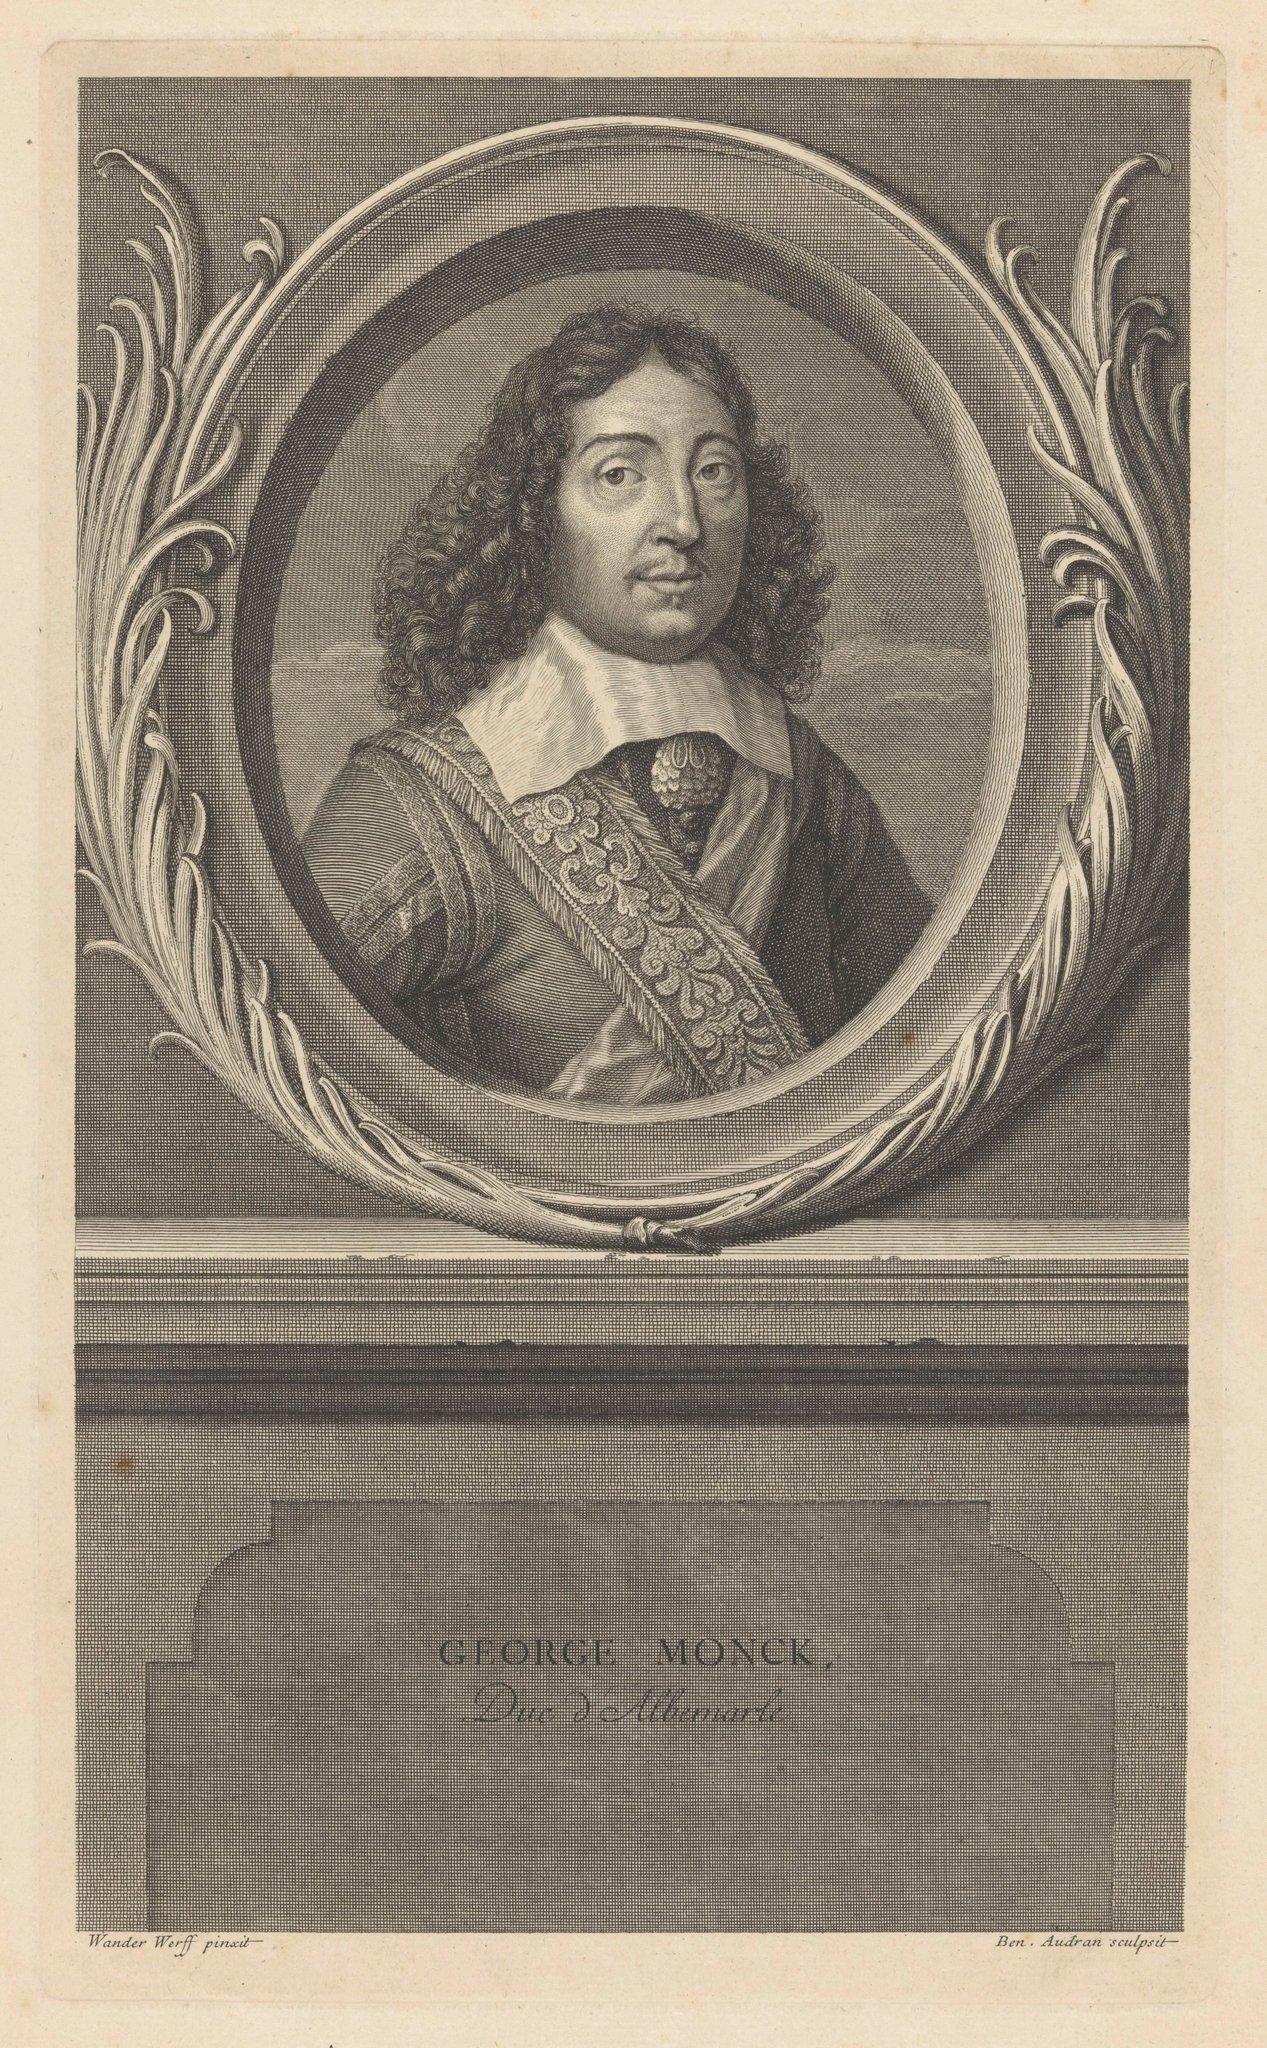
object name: print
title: Portret van George Monck, hertog van Albemarle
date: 1671-1721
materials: paper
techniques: engraving, etching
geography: paris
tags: admiraal, staatsman, george monck (hertog van albemarle)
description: Portret van George Monck in een geornamenteerde, ovale omlijsting. In een kader zijn naam en titel.